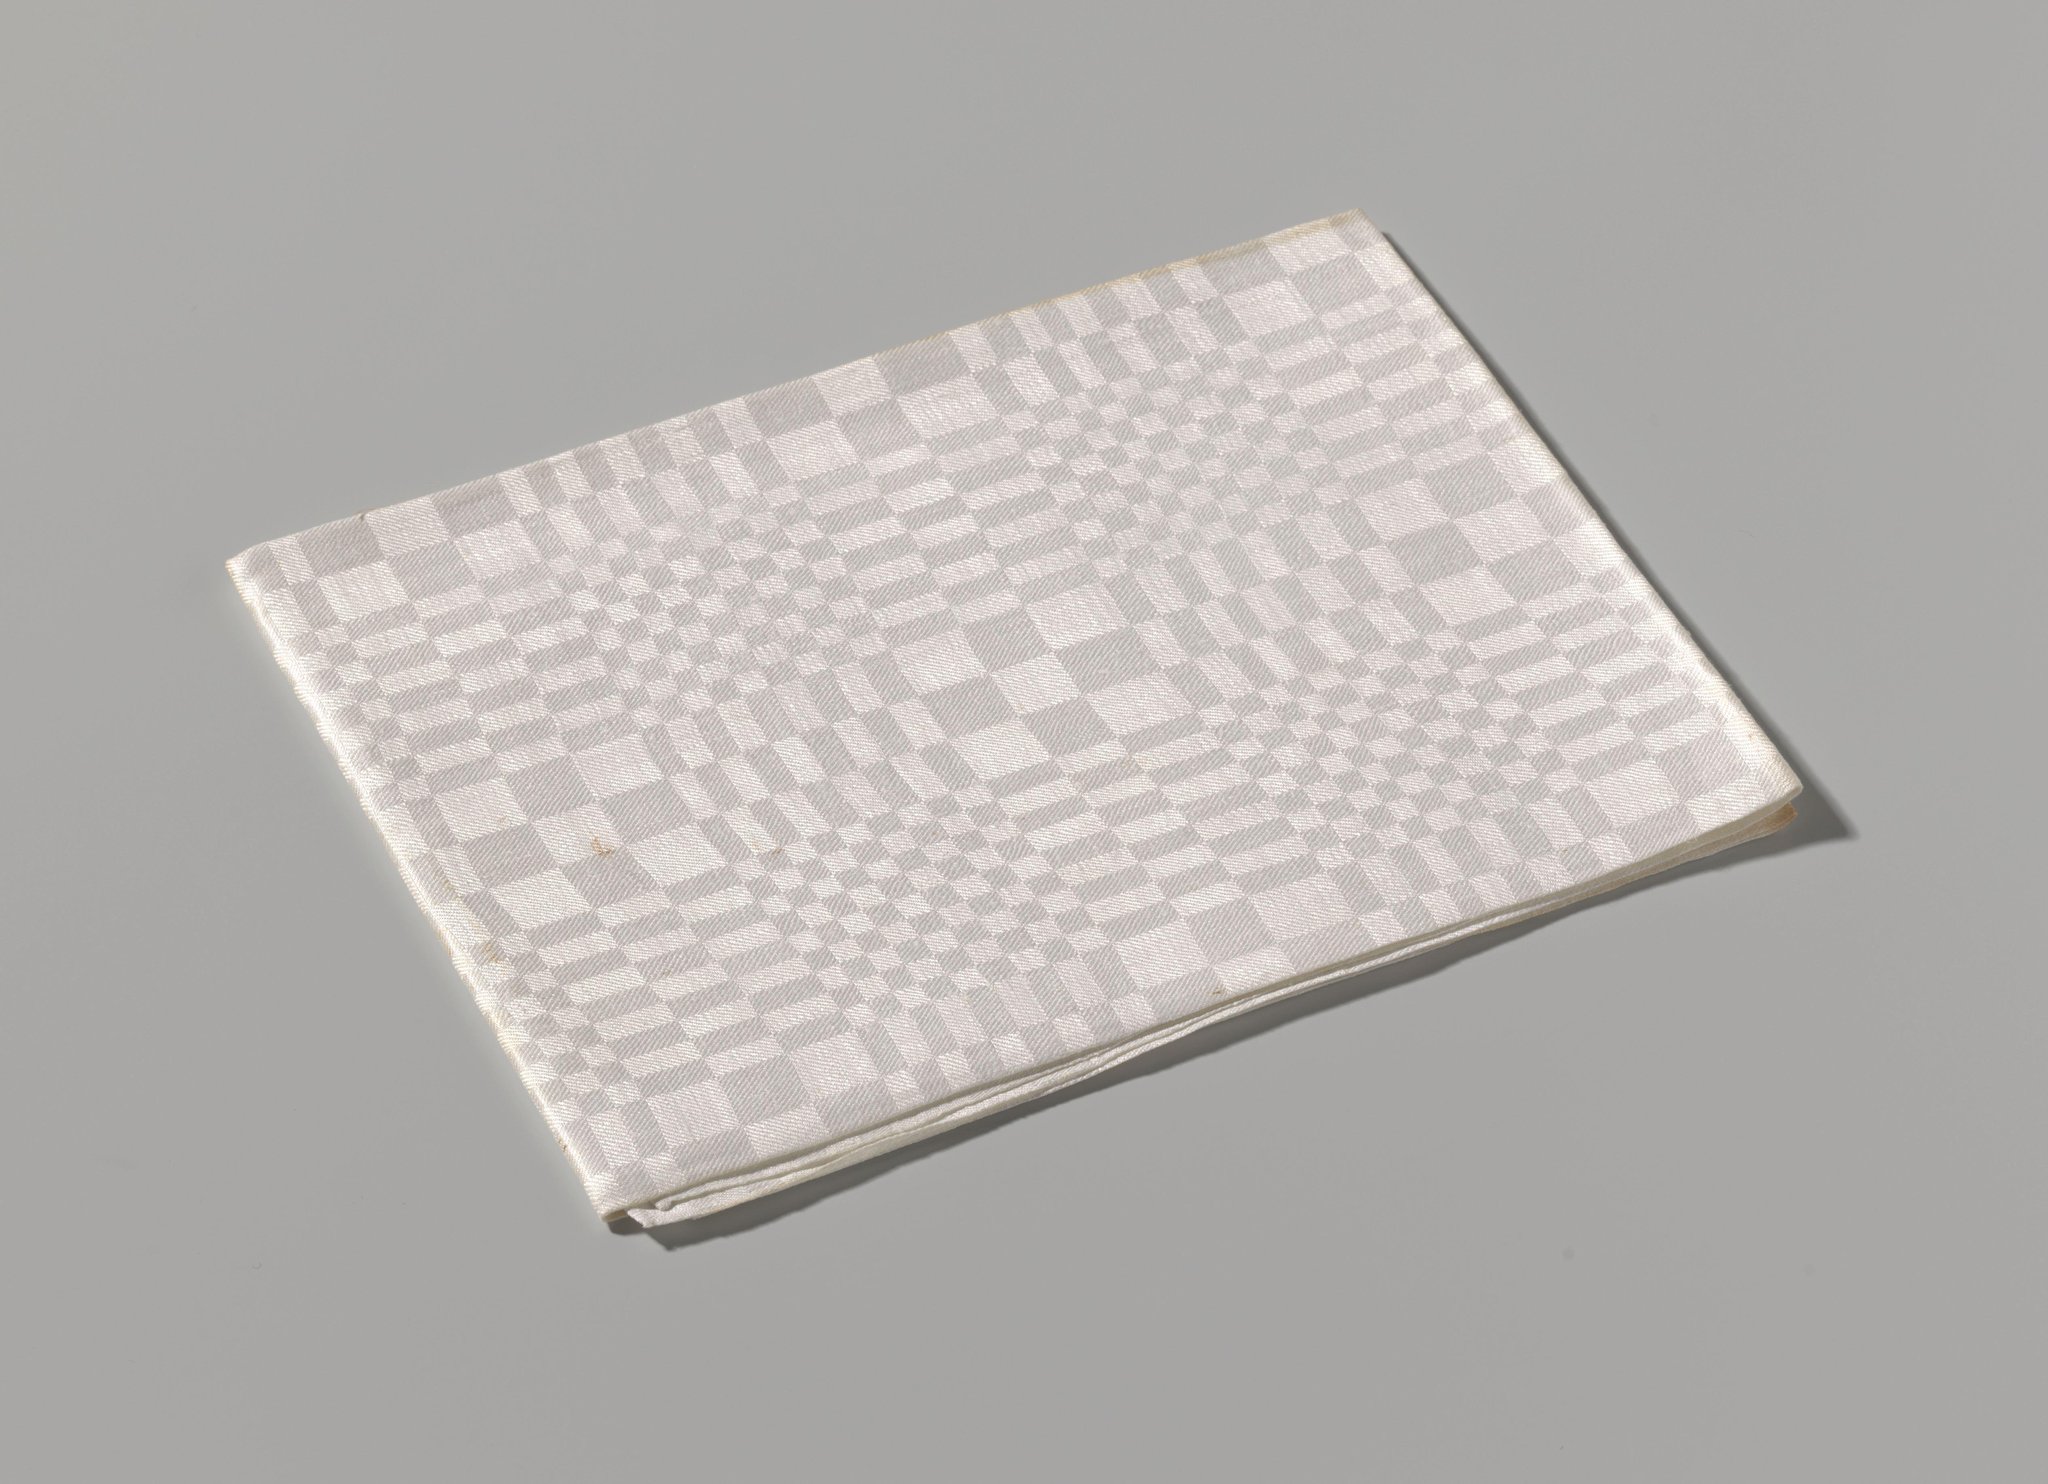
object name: napkin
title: Servet van linnen met pellenpatroon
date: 1784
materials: linen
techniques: twill, peeled fabric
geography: northern netherlands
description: wit linnen servet met pellen patroon, z.g. Engelse garderobe, merk WS 104 en 1784